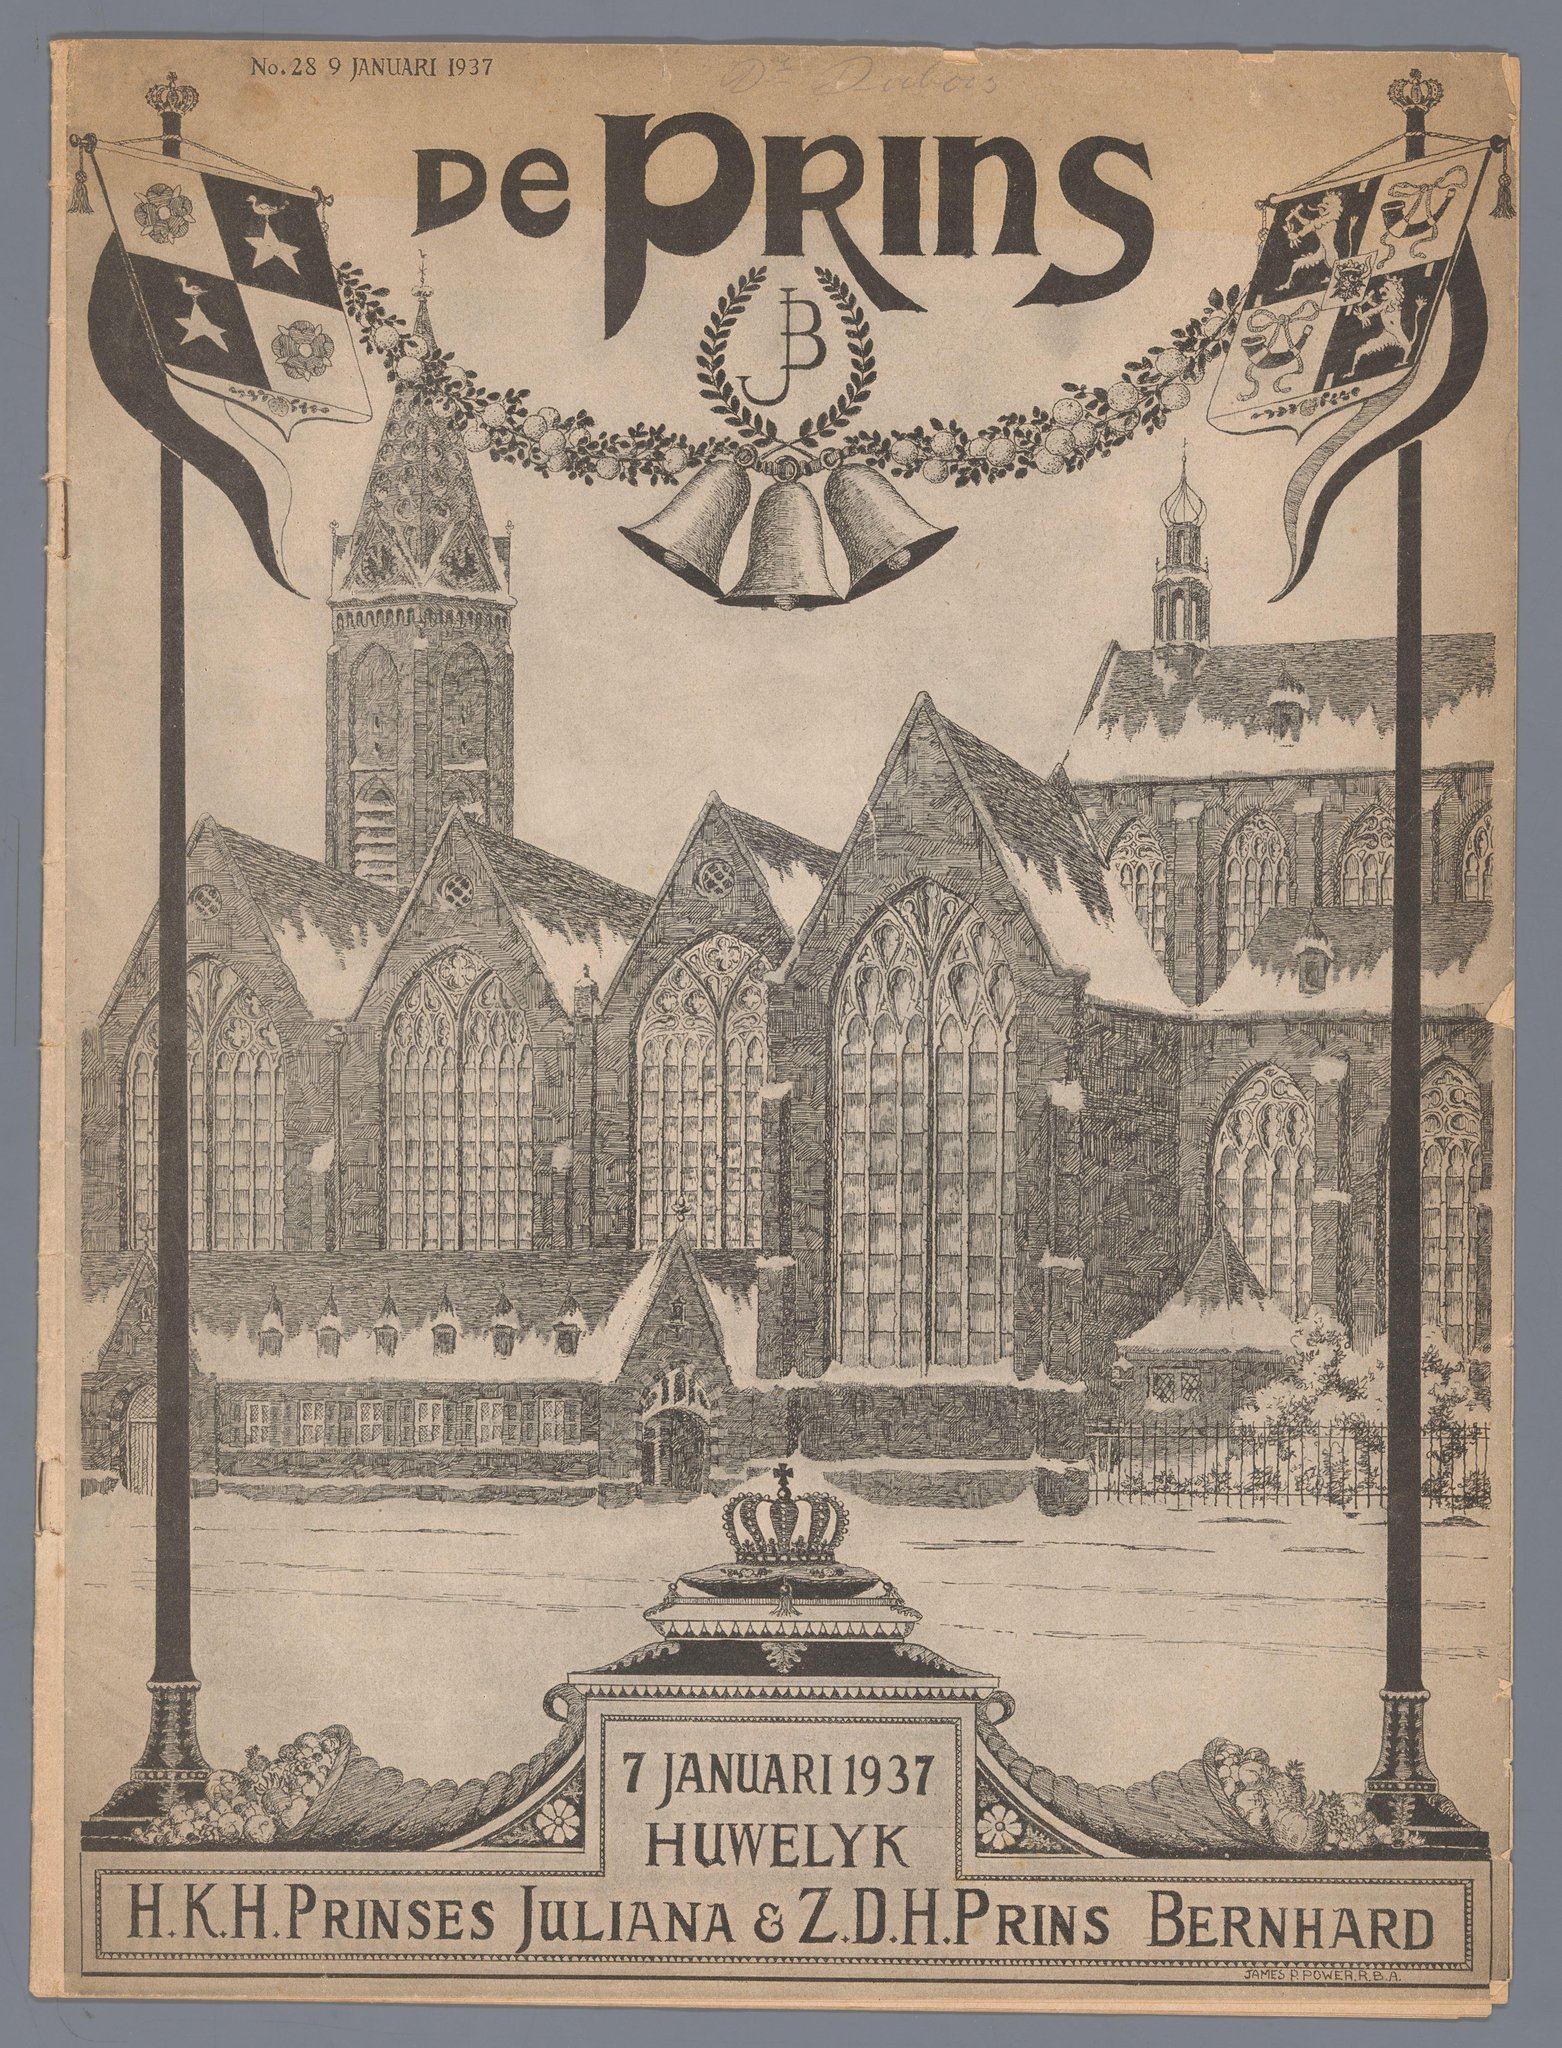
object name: magazine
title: De Prins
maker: gerrit jan thieme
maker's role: print maker, printer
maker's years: 1827-1889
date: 1937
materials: paper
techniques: printing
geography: amsterdam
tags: utrecht, bernhard (prins der nederlanden), the hague, juliana of the netherlands, netherlands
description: Tijdschrift over het huwelijk van Juliana en Bernhard, pp 26 t/m 47 in papieren omslag.